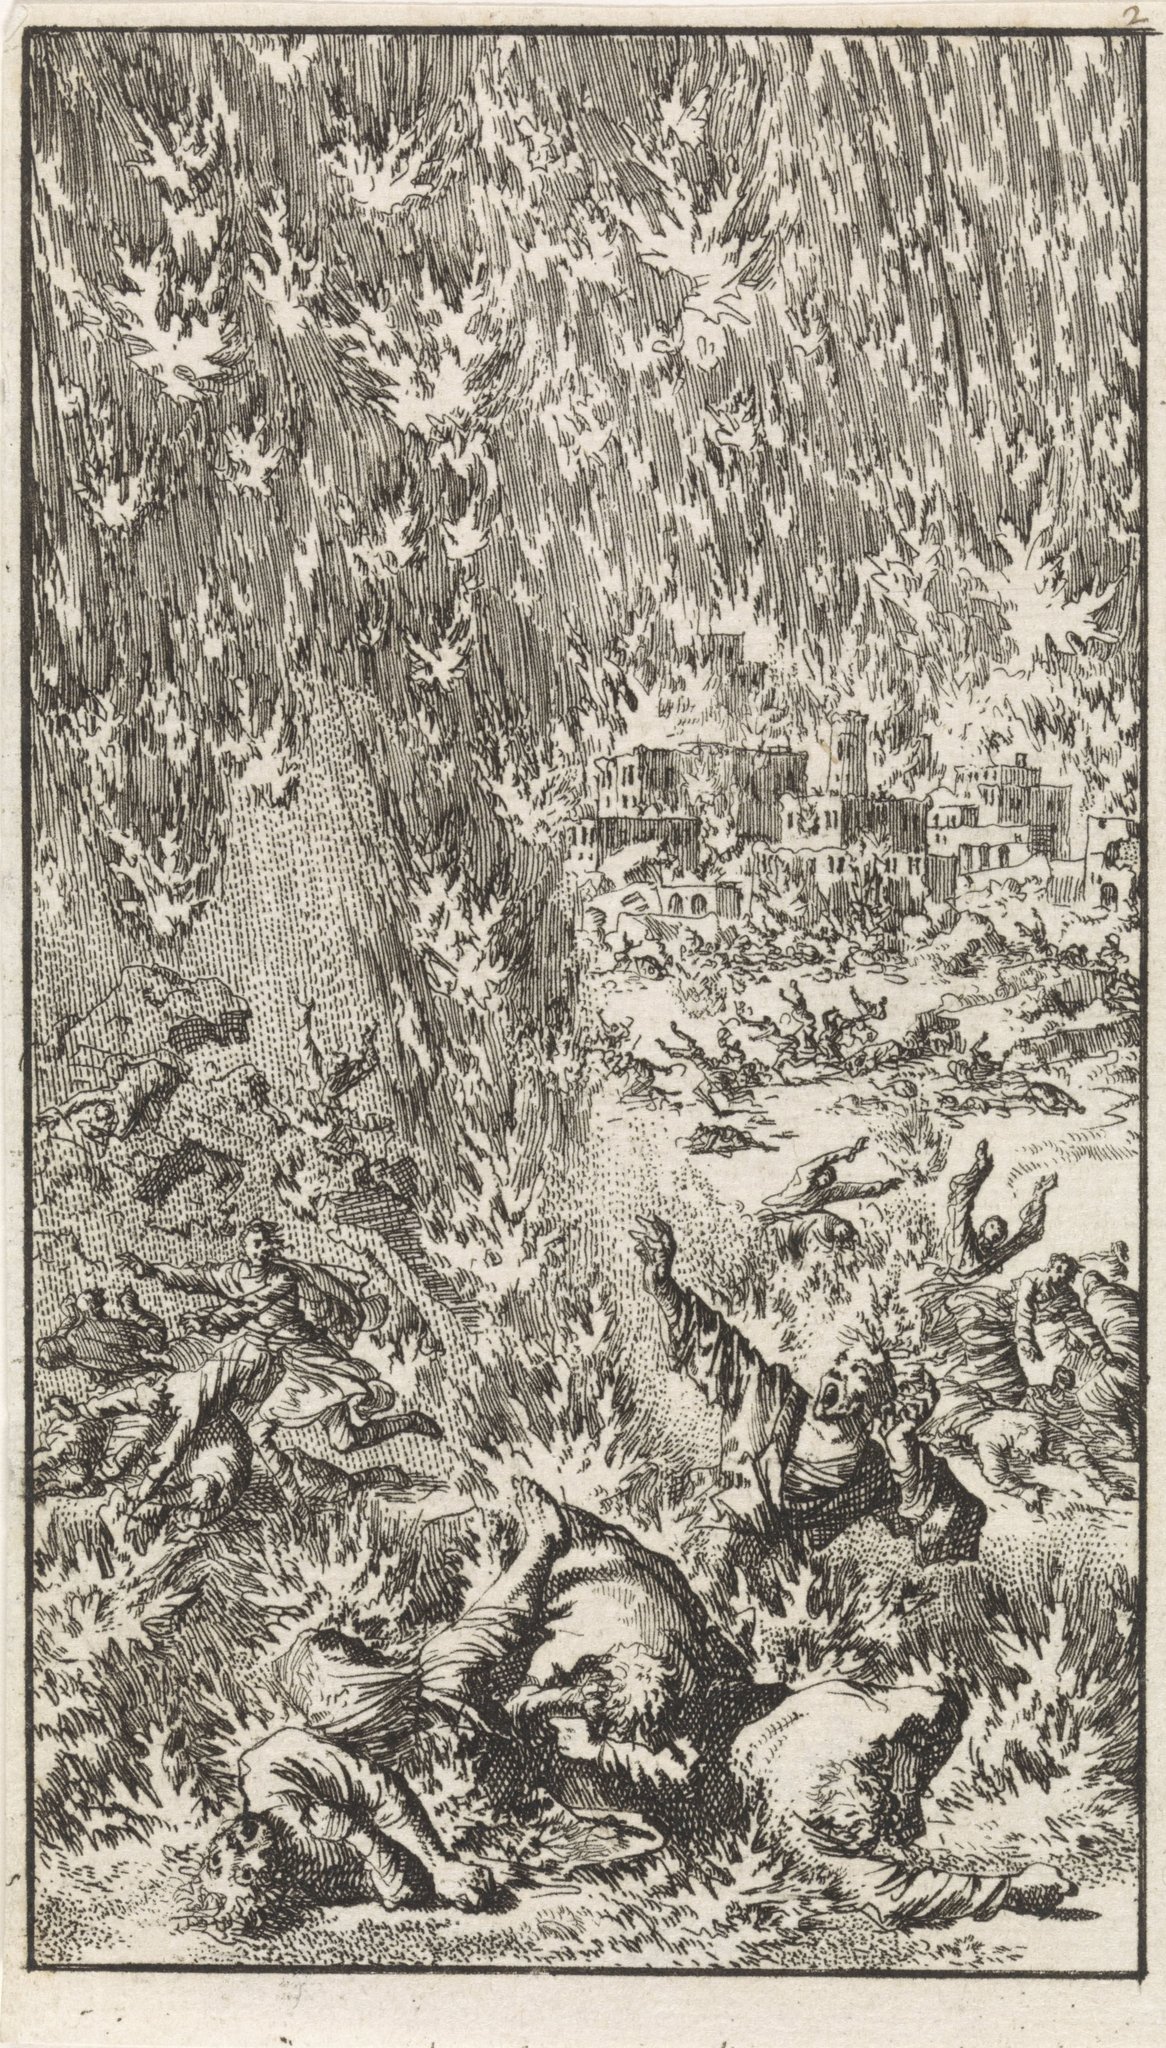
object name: print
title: Vernietiging van Sodom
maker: jan luyken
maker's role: draughtsman, print maker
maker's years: 1649-1712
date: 1712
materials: paper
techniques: etching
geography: amsterdam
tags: sodom and gomorrah burning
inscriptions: collector's mark: Lugt 2228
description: Proefdruk van illustratie voor: Luyken, Jan. Bybel printen. Amsterdam: Pieter Arentsz. II (wed.) en Cornelis van der Sys, 1712, p. 3.